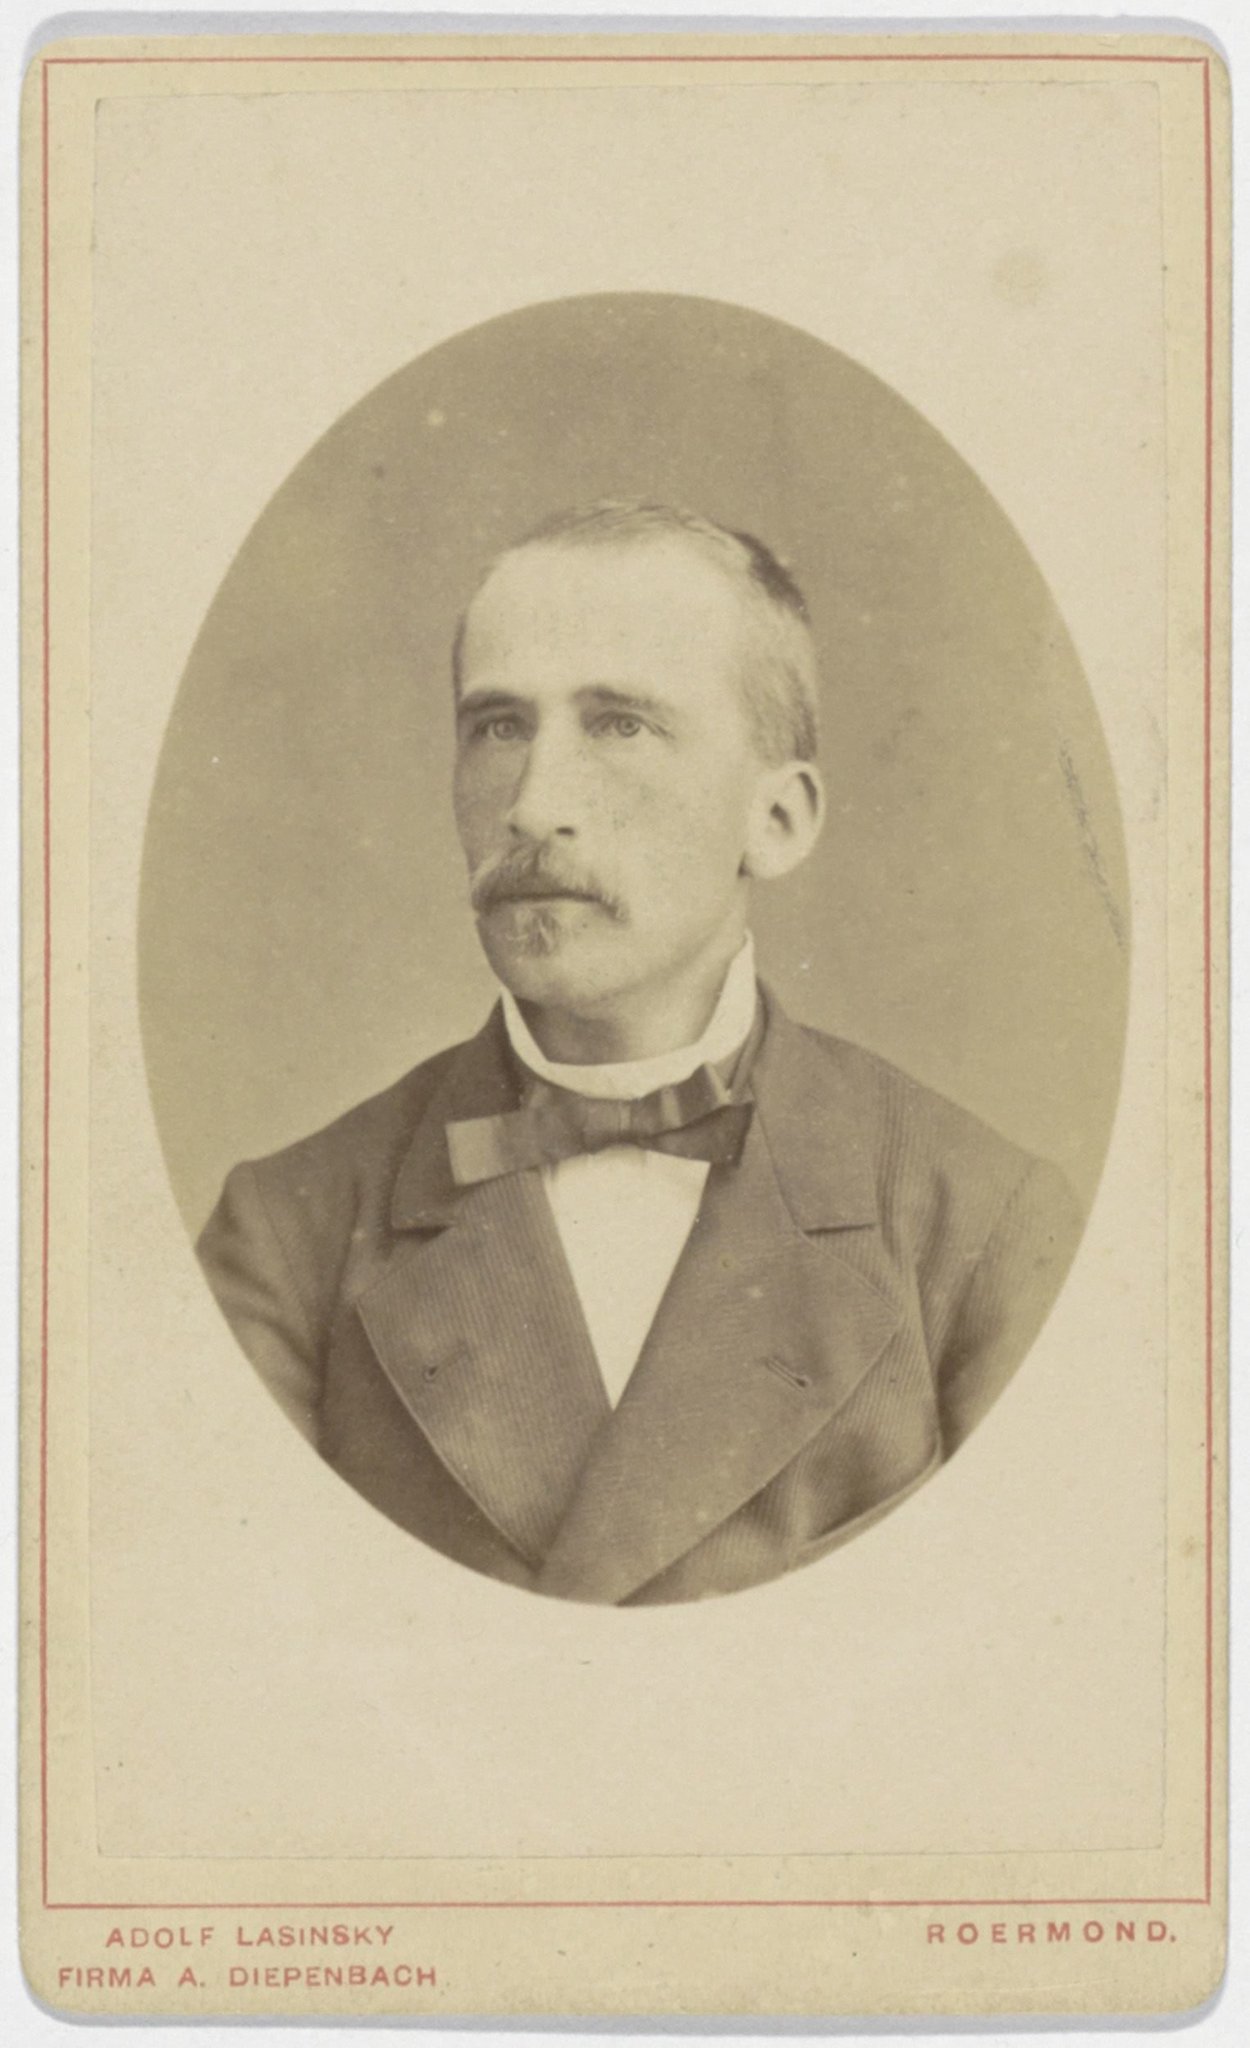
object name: photograph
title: Portret van een man met een snor en een strikje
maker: adolf lasinsky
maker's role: fotograaf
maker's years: 1849-1891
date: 1860-1900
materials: cardboard, paper, photographic support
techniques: albumen print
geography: roermond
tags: moustache, historical persons, neck-gear ~ clothing, clothing for the upper part of the body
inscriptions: address: ‘Roermond’, name: ‘Adolf Lasinsky firma A. Diepenbach’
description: Onderdeel van Fotoalbum van een Nederlandse familie met 168 cartes-de-visite en kabinetfoto's.